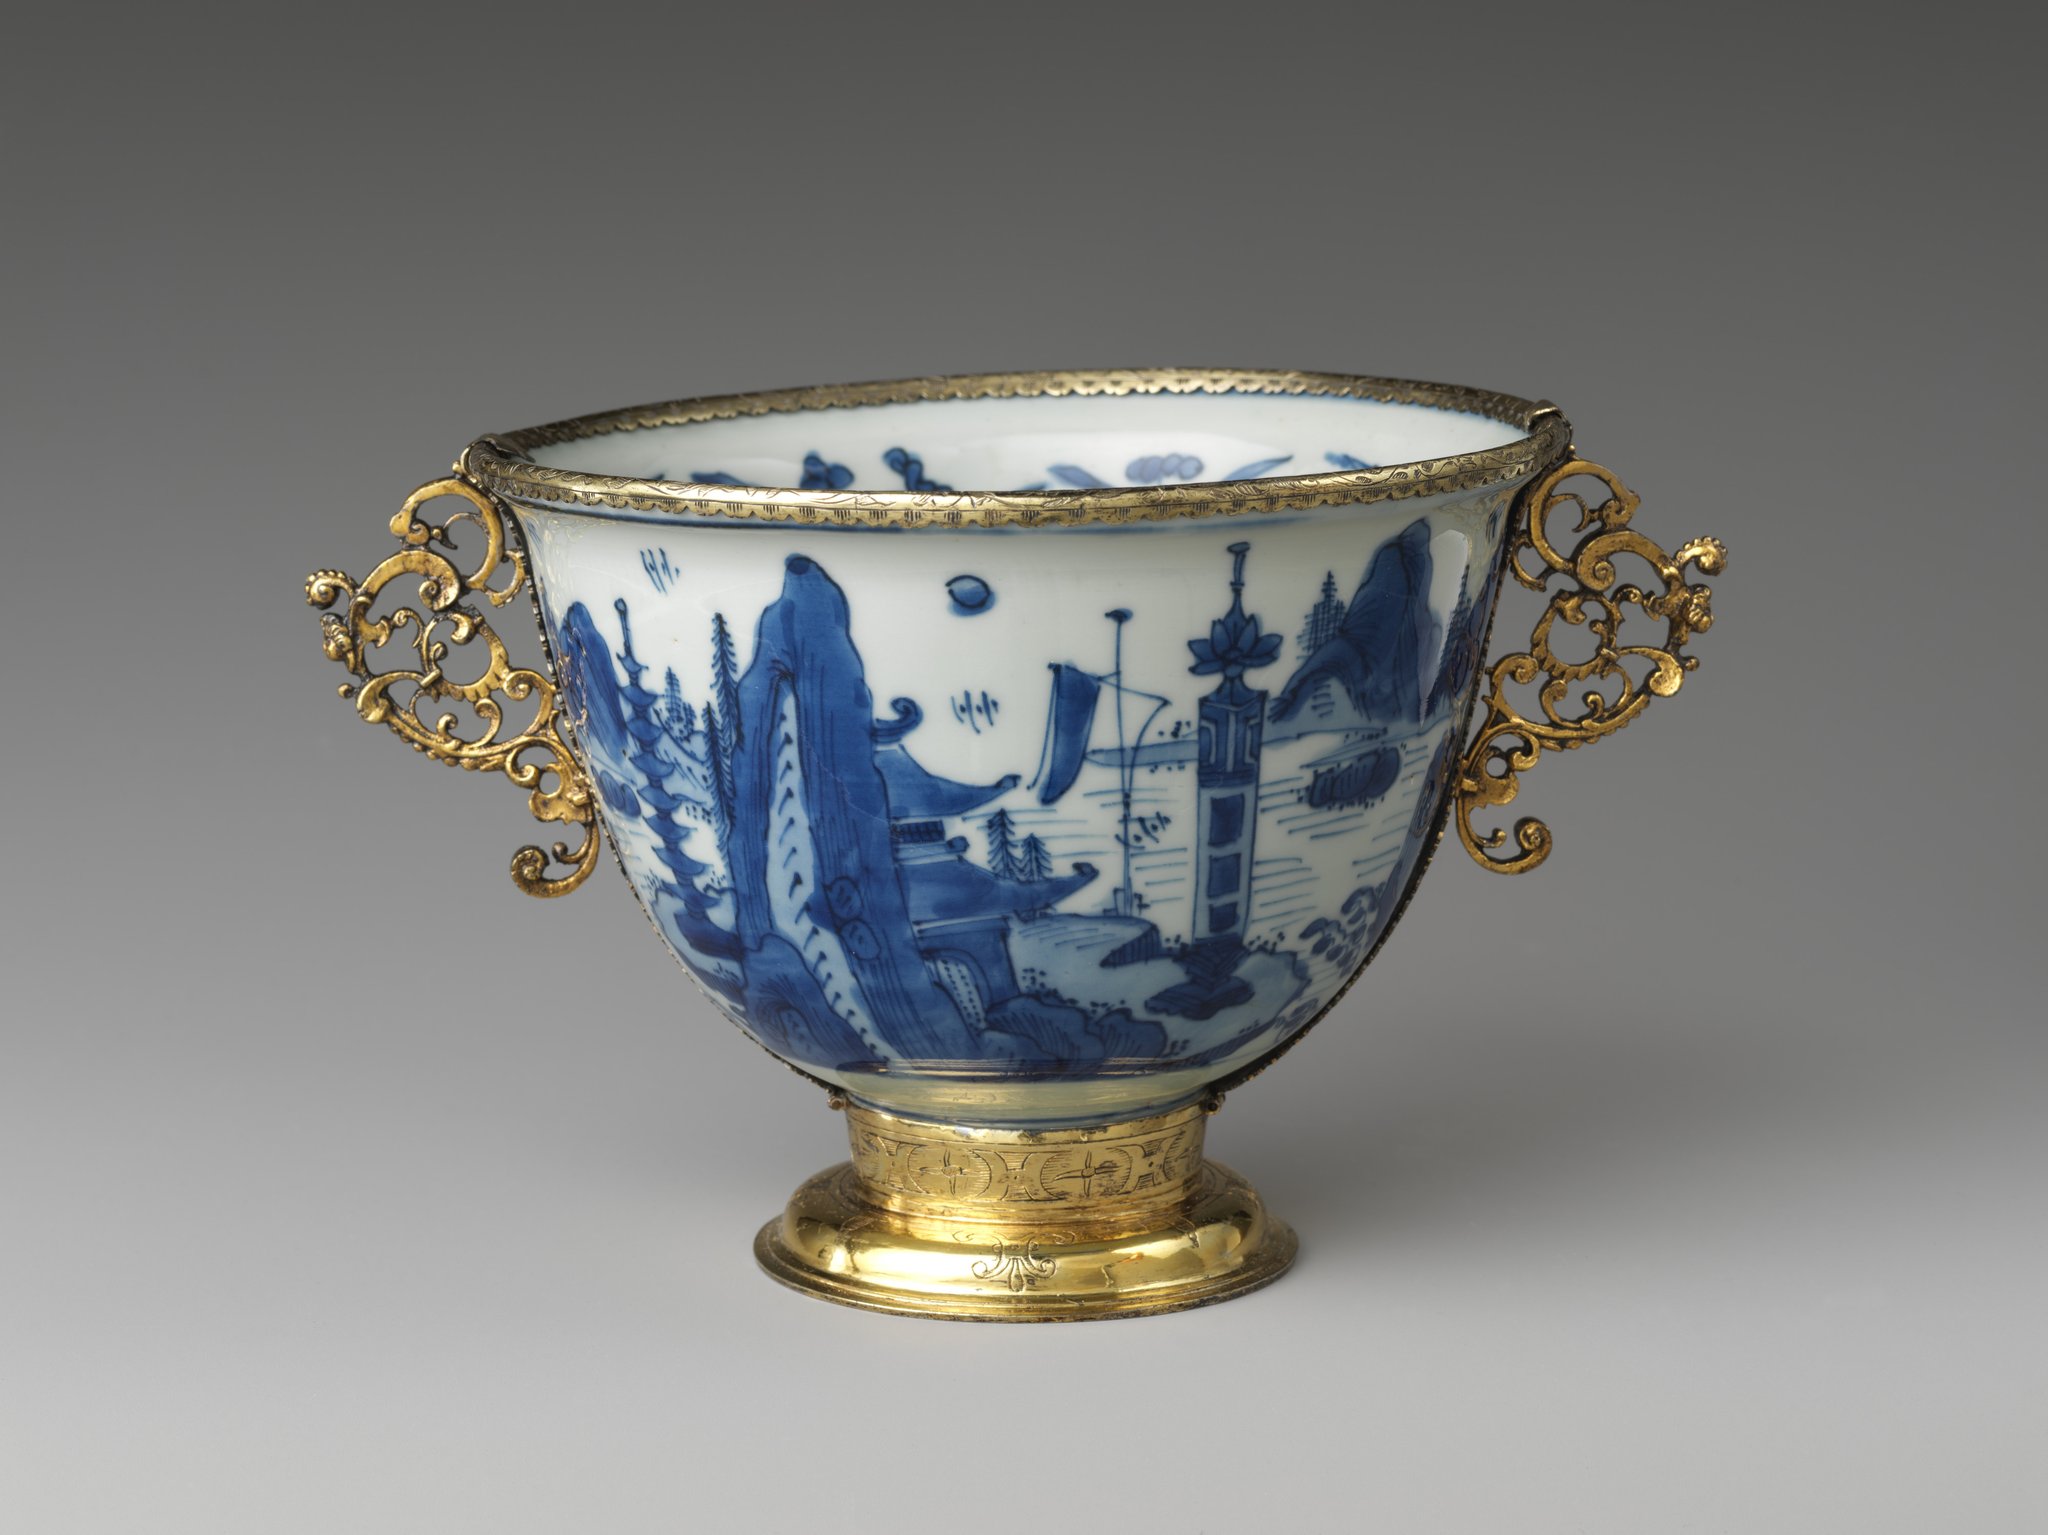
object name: bowl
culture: chinese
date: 1567-1600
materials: silver gilt, porcelain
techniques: painting, underglaze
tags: landscapes